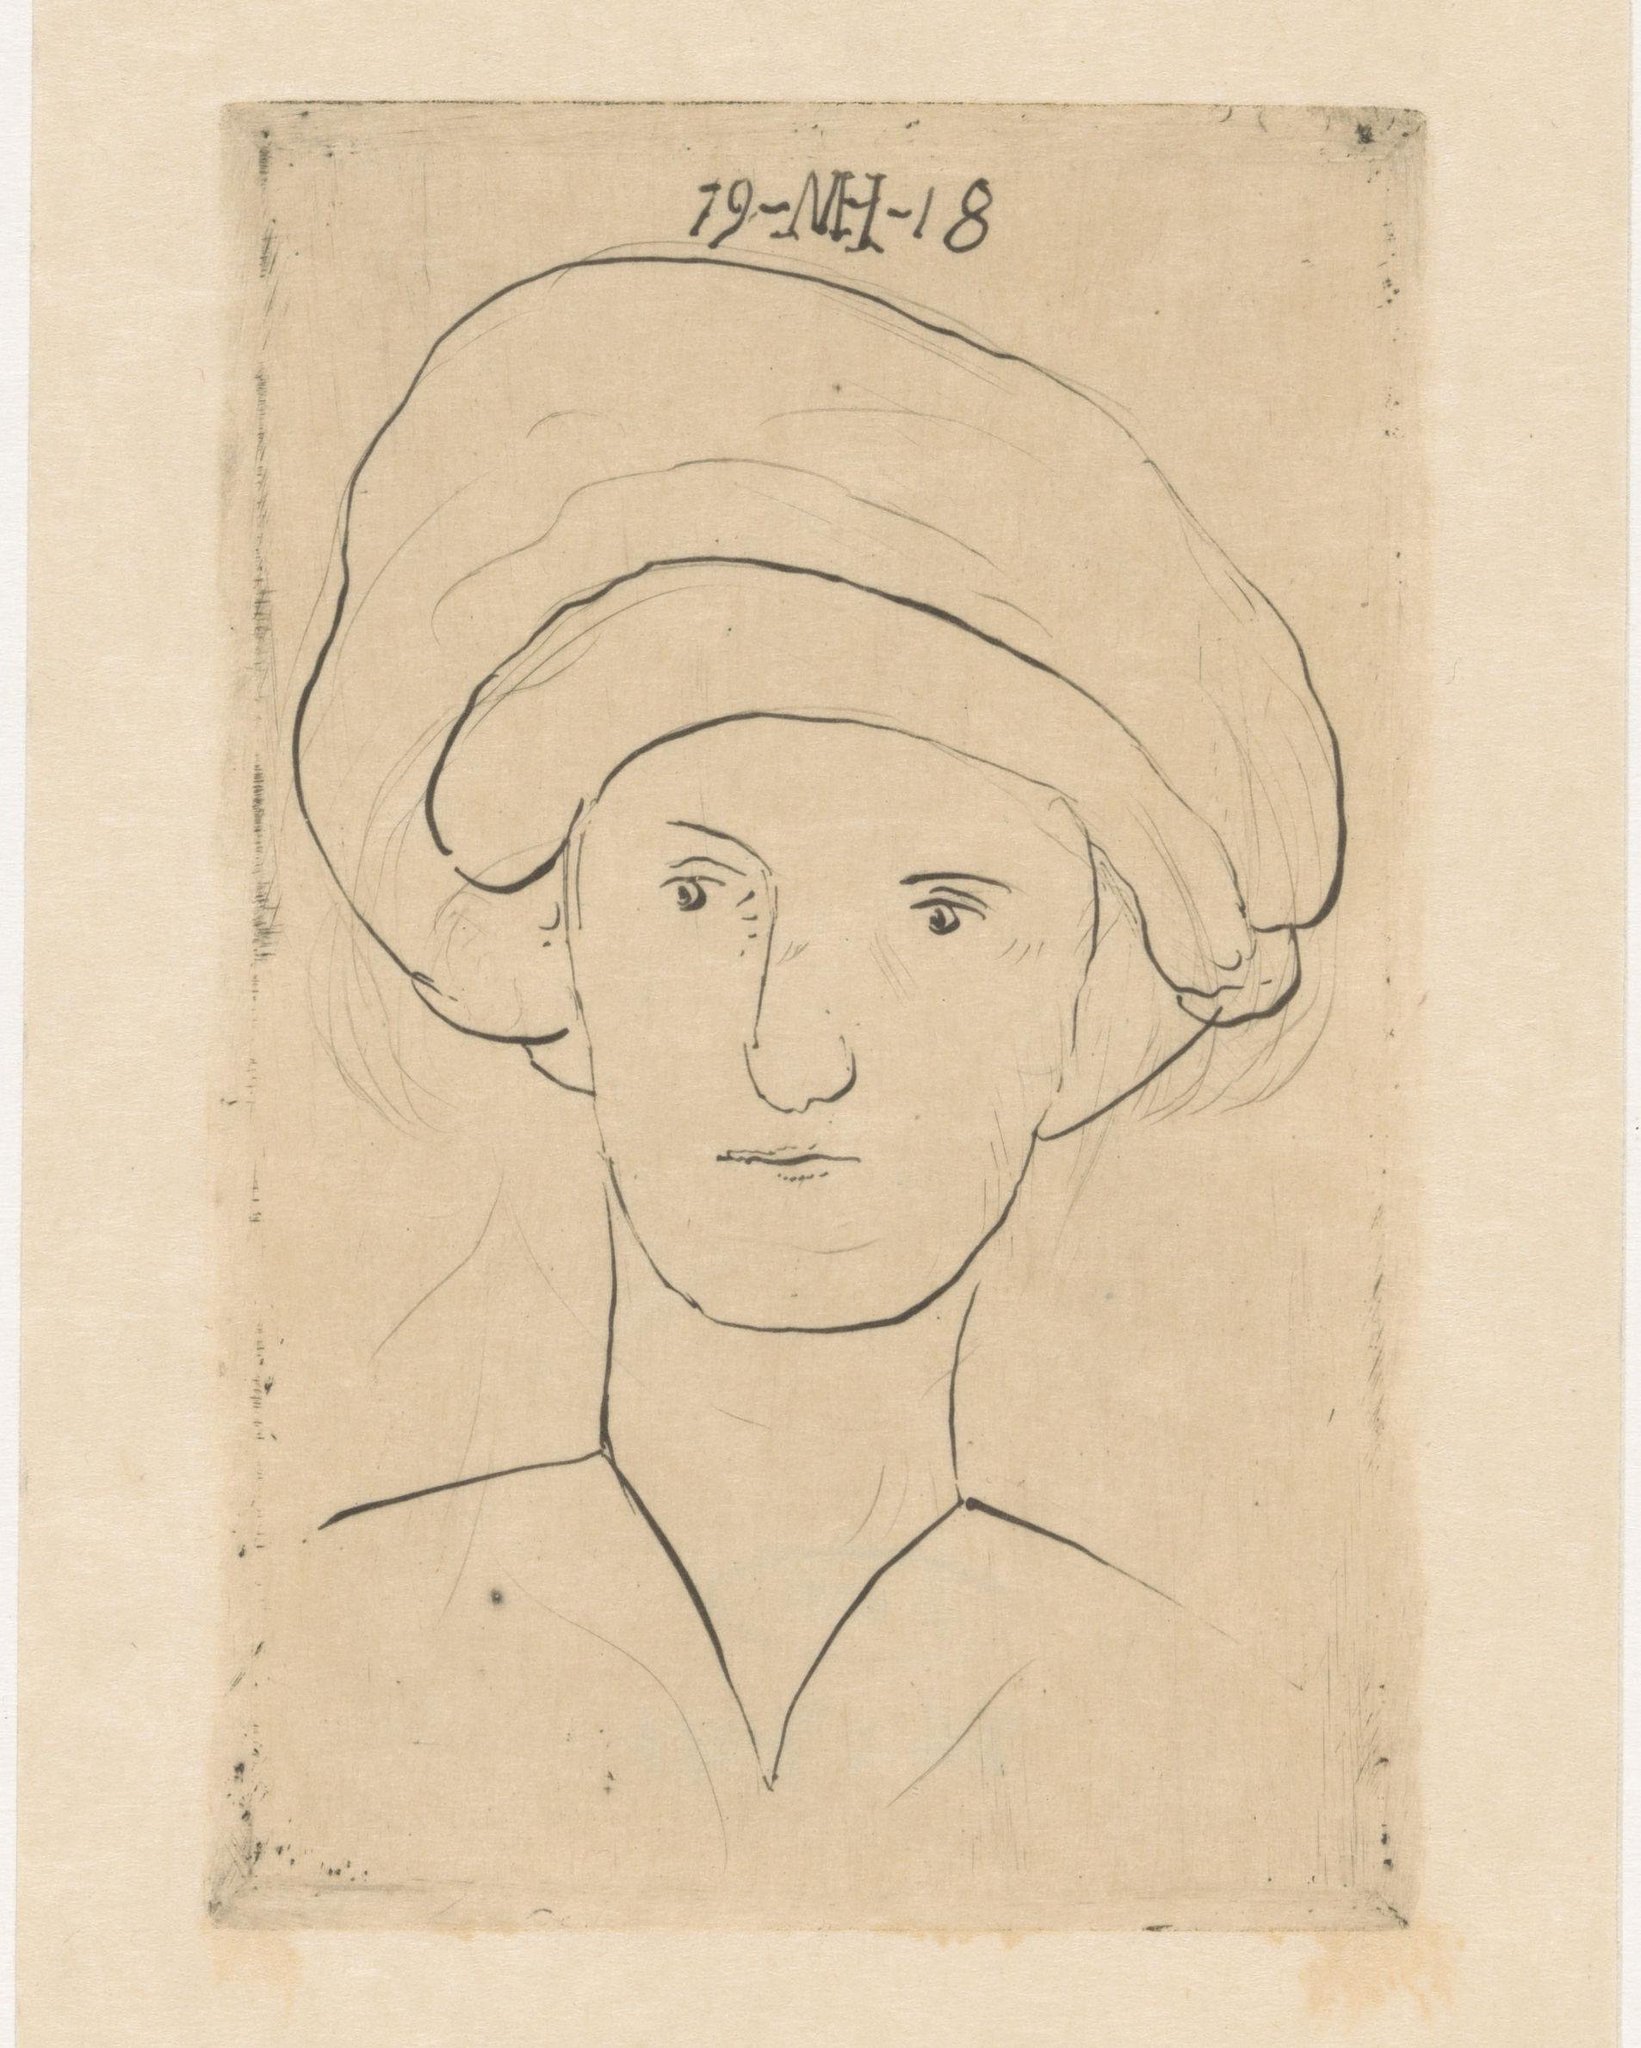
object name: print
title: Jonge man met tulband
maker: marius holleman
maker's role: draughtsman, print maker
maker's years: 1878-1926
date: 1918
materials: paper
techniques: etching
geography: groningen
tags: youth, adolescent, head-gear: turban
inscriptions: collector's mark: Lugt 2228